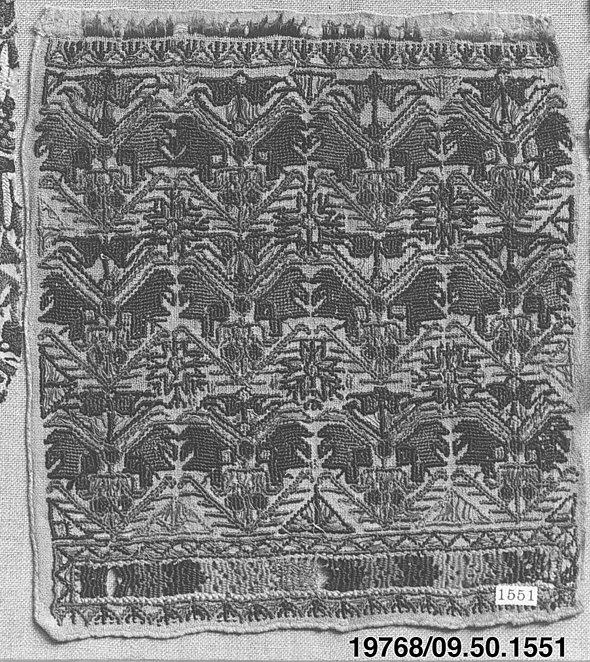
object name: fragment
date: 1801-1900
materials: linen, silk